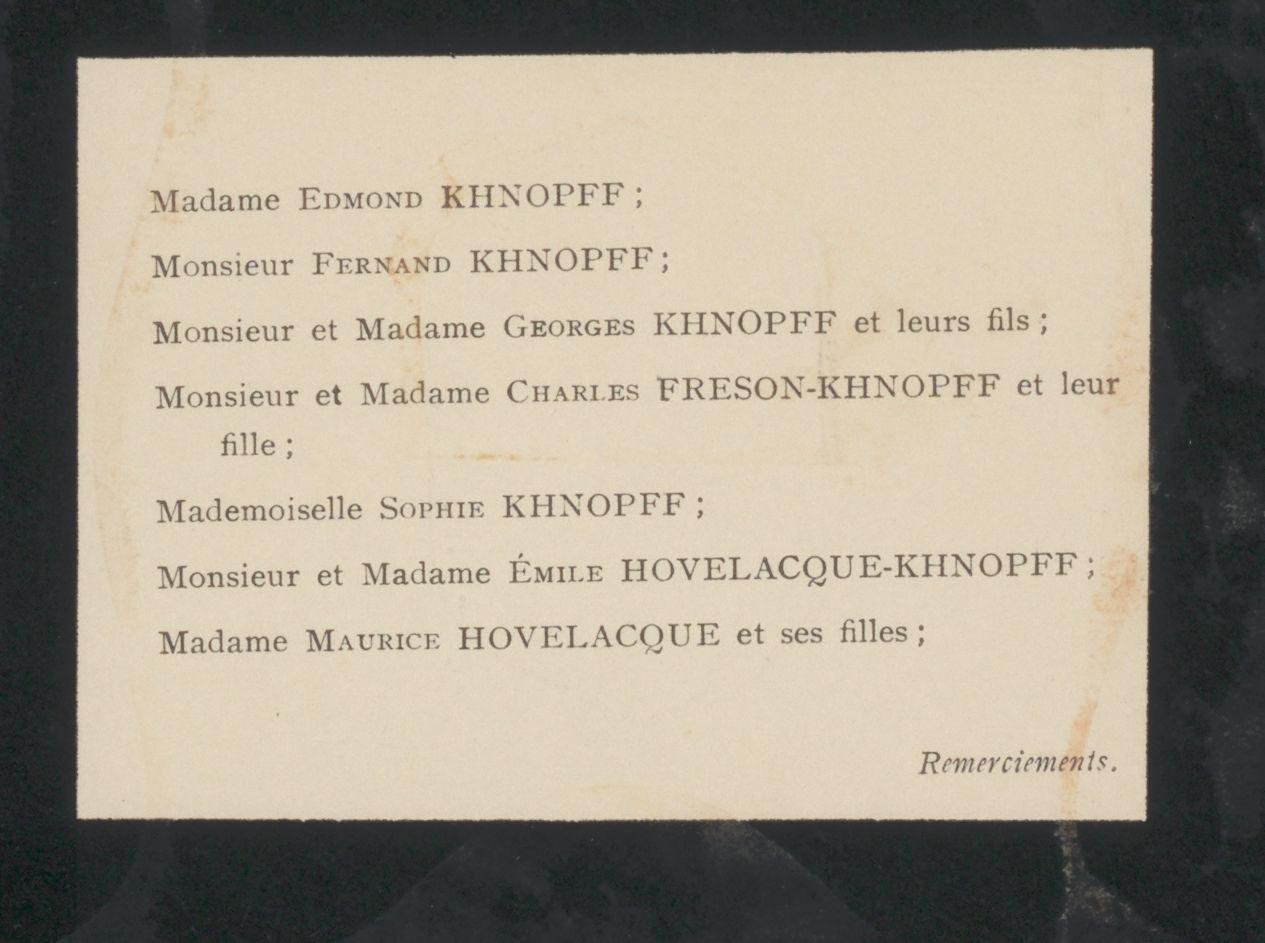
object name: overlijdensbericht, overlijdensadvertentie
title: Dankbetuiging aan Philip Zilcken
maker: Anonymous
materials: paper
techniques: printing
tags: brussels, print maker, draughtsman, fernand khnopff, painter, philip zilcken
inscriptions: collector's mark: ‘RPK’